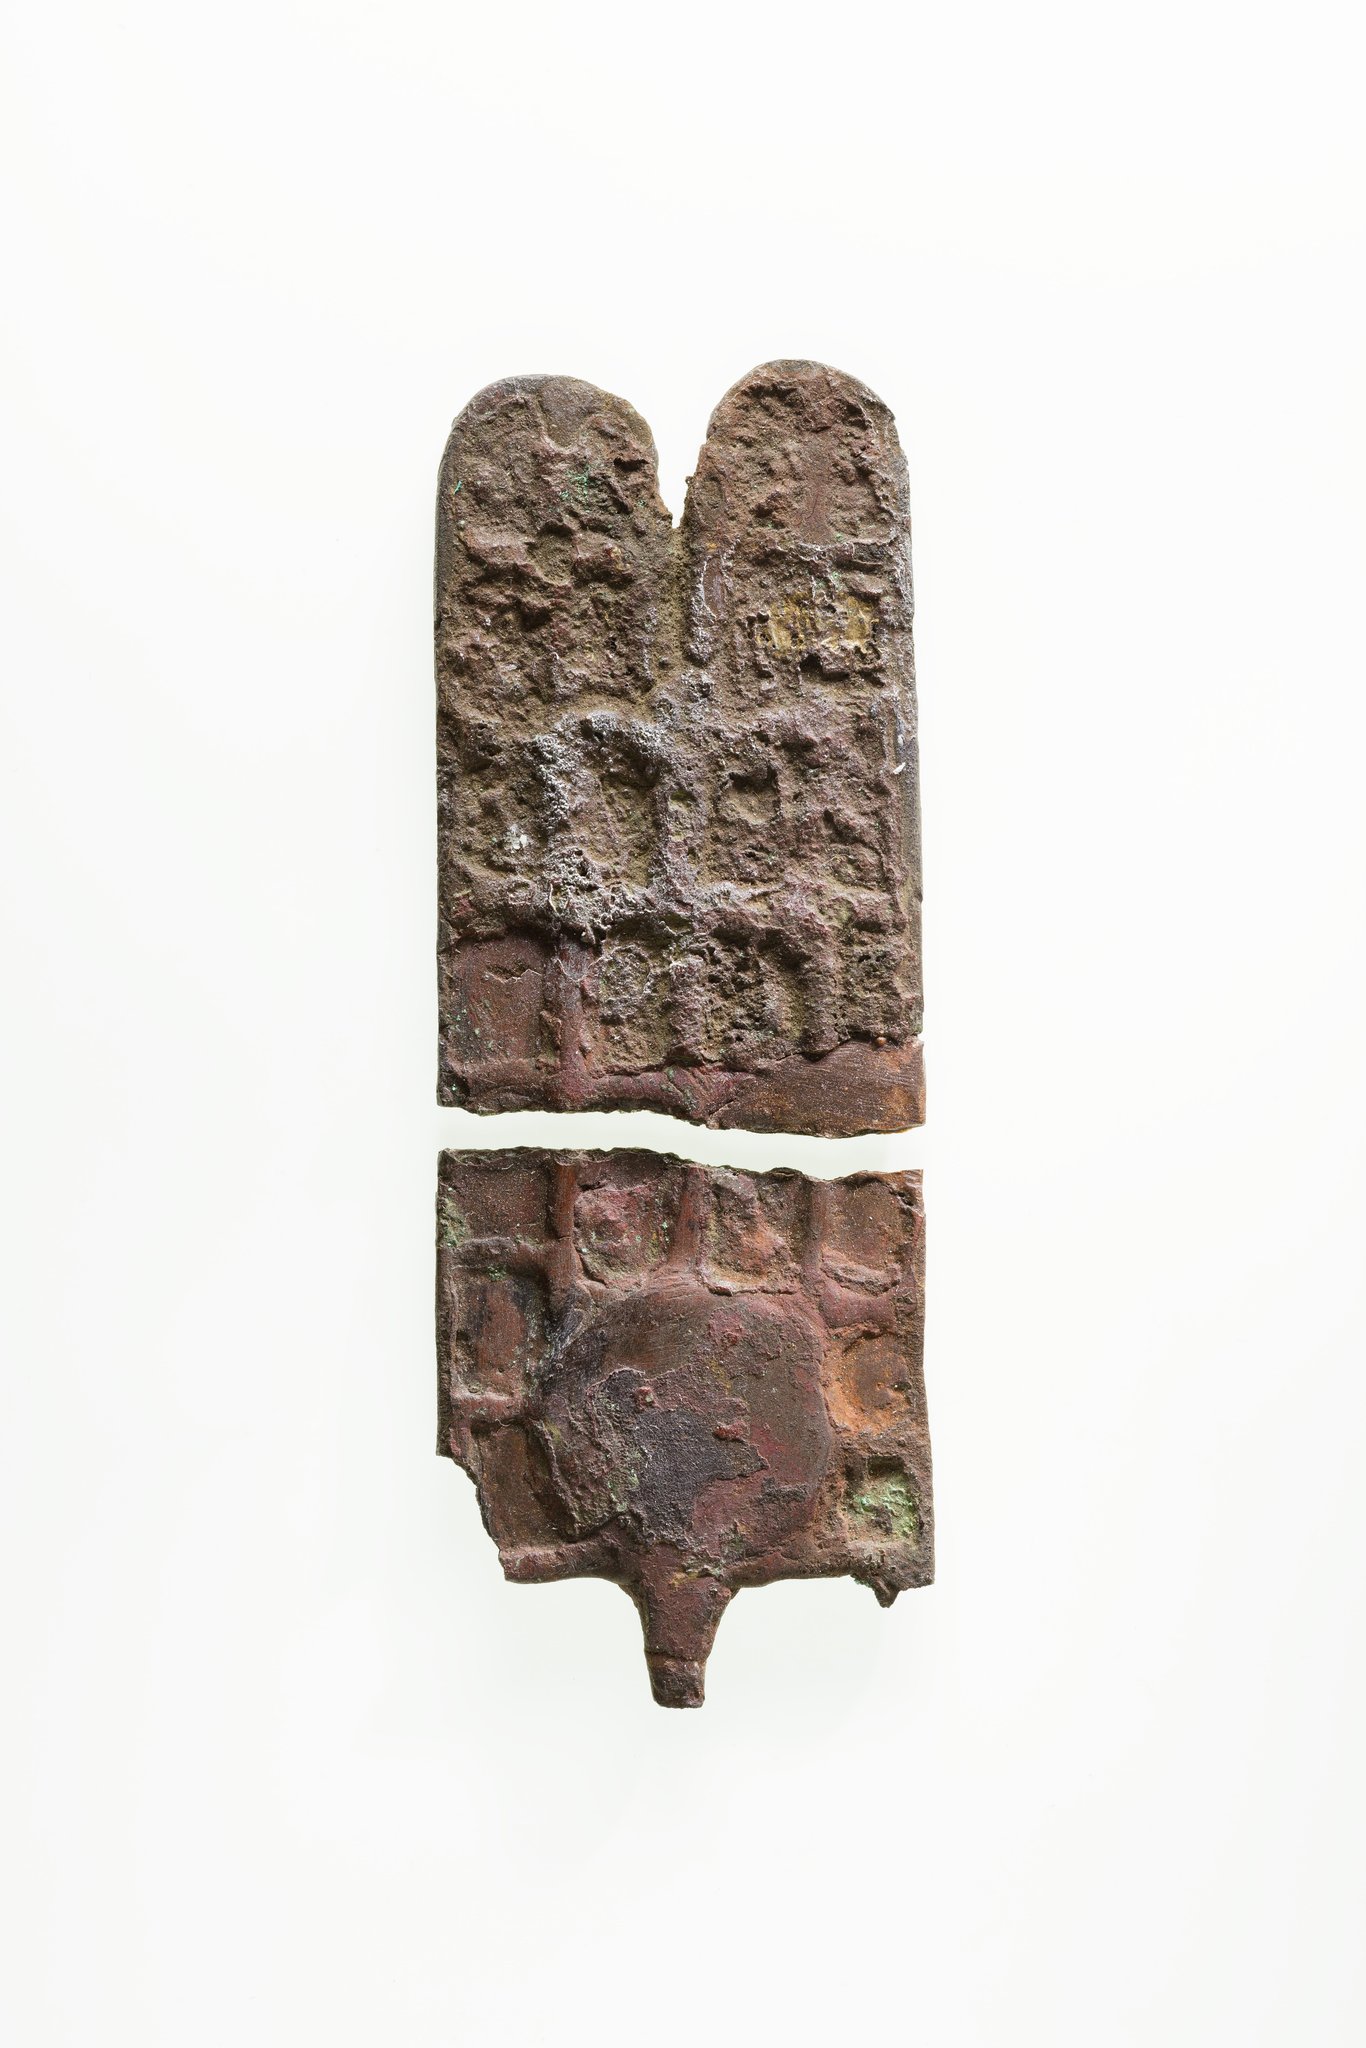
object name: statuette fragment, pair of feather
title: Statuette fragment, pair of feathers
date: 712-30 BCE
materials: bronze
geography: egypt